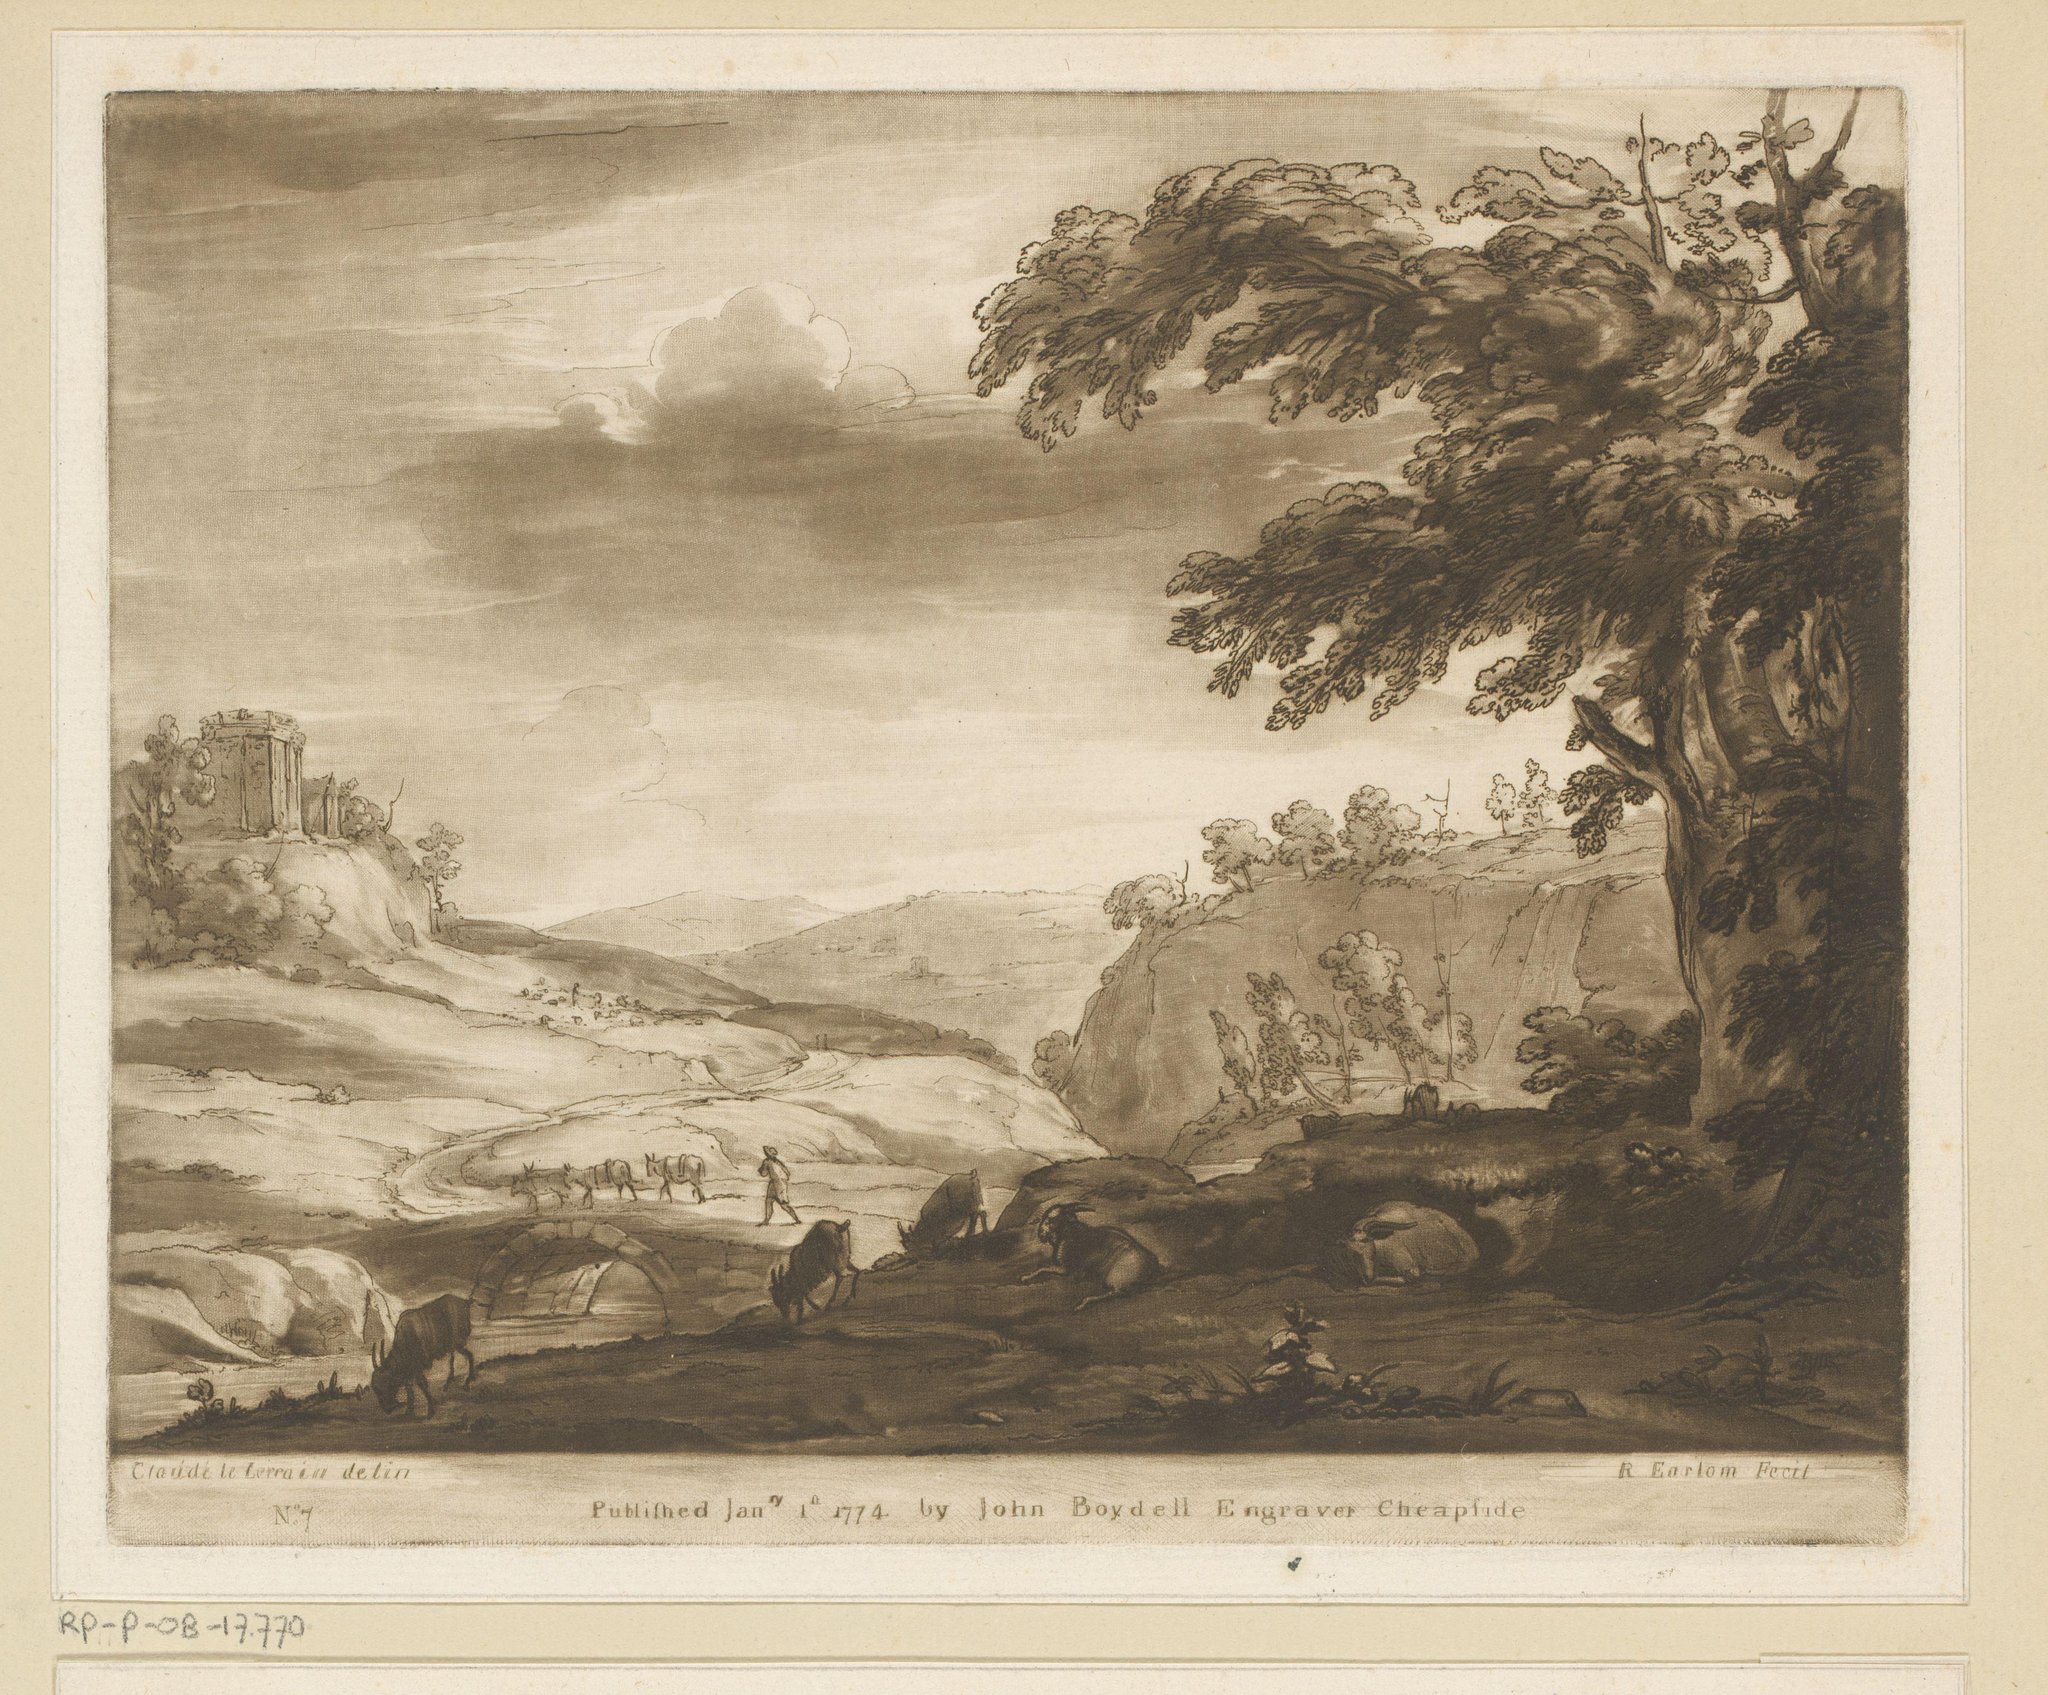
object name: print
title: Bergachtig landschap met brug over een rivier, herder en geiten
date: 1774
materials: paper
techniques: etching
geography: london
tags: river, landscape with bridge, viaduct or aqueduct, cattle driving, cattle driver, goat, mountains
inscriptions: date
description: Vanaf 1774 publiceerde John Boydell tweehonderd prenten naar het tekeningenboek Liber Veritatis van Claude Lorrain, in het bezit van de hertogen van Cavendish. Deze prenten werden vanaf 1777 in twee volumes gebundeld uitgegeven.